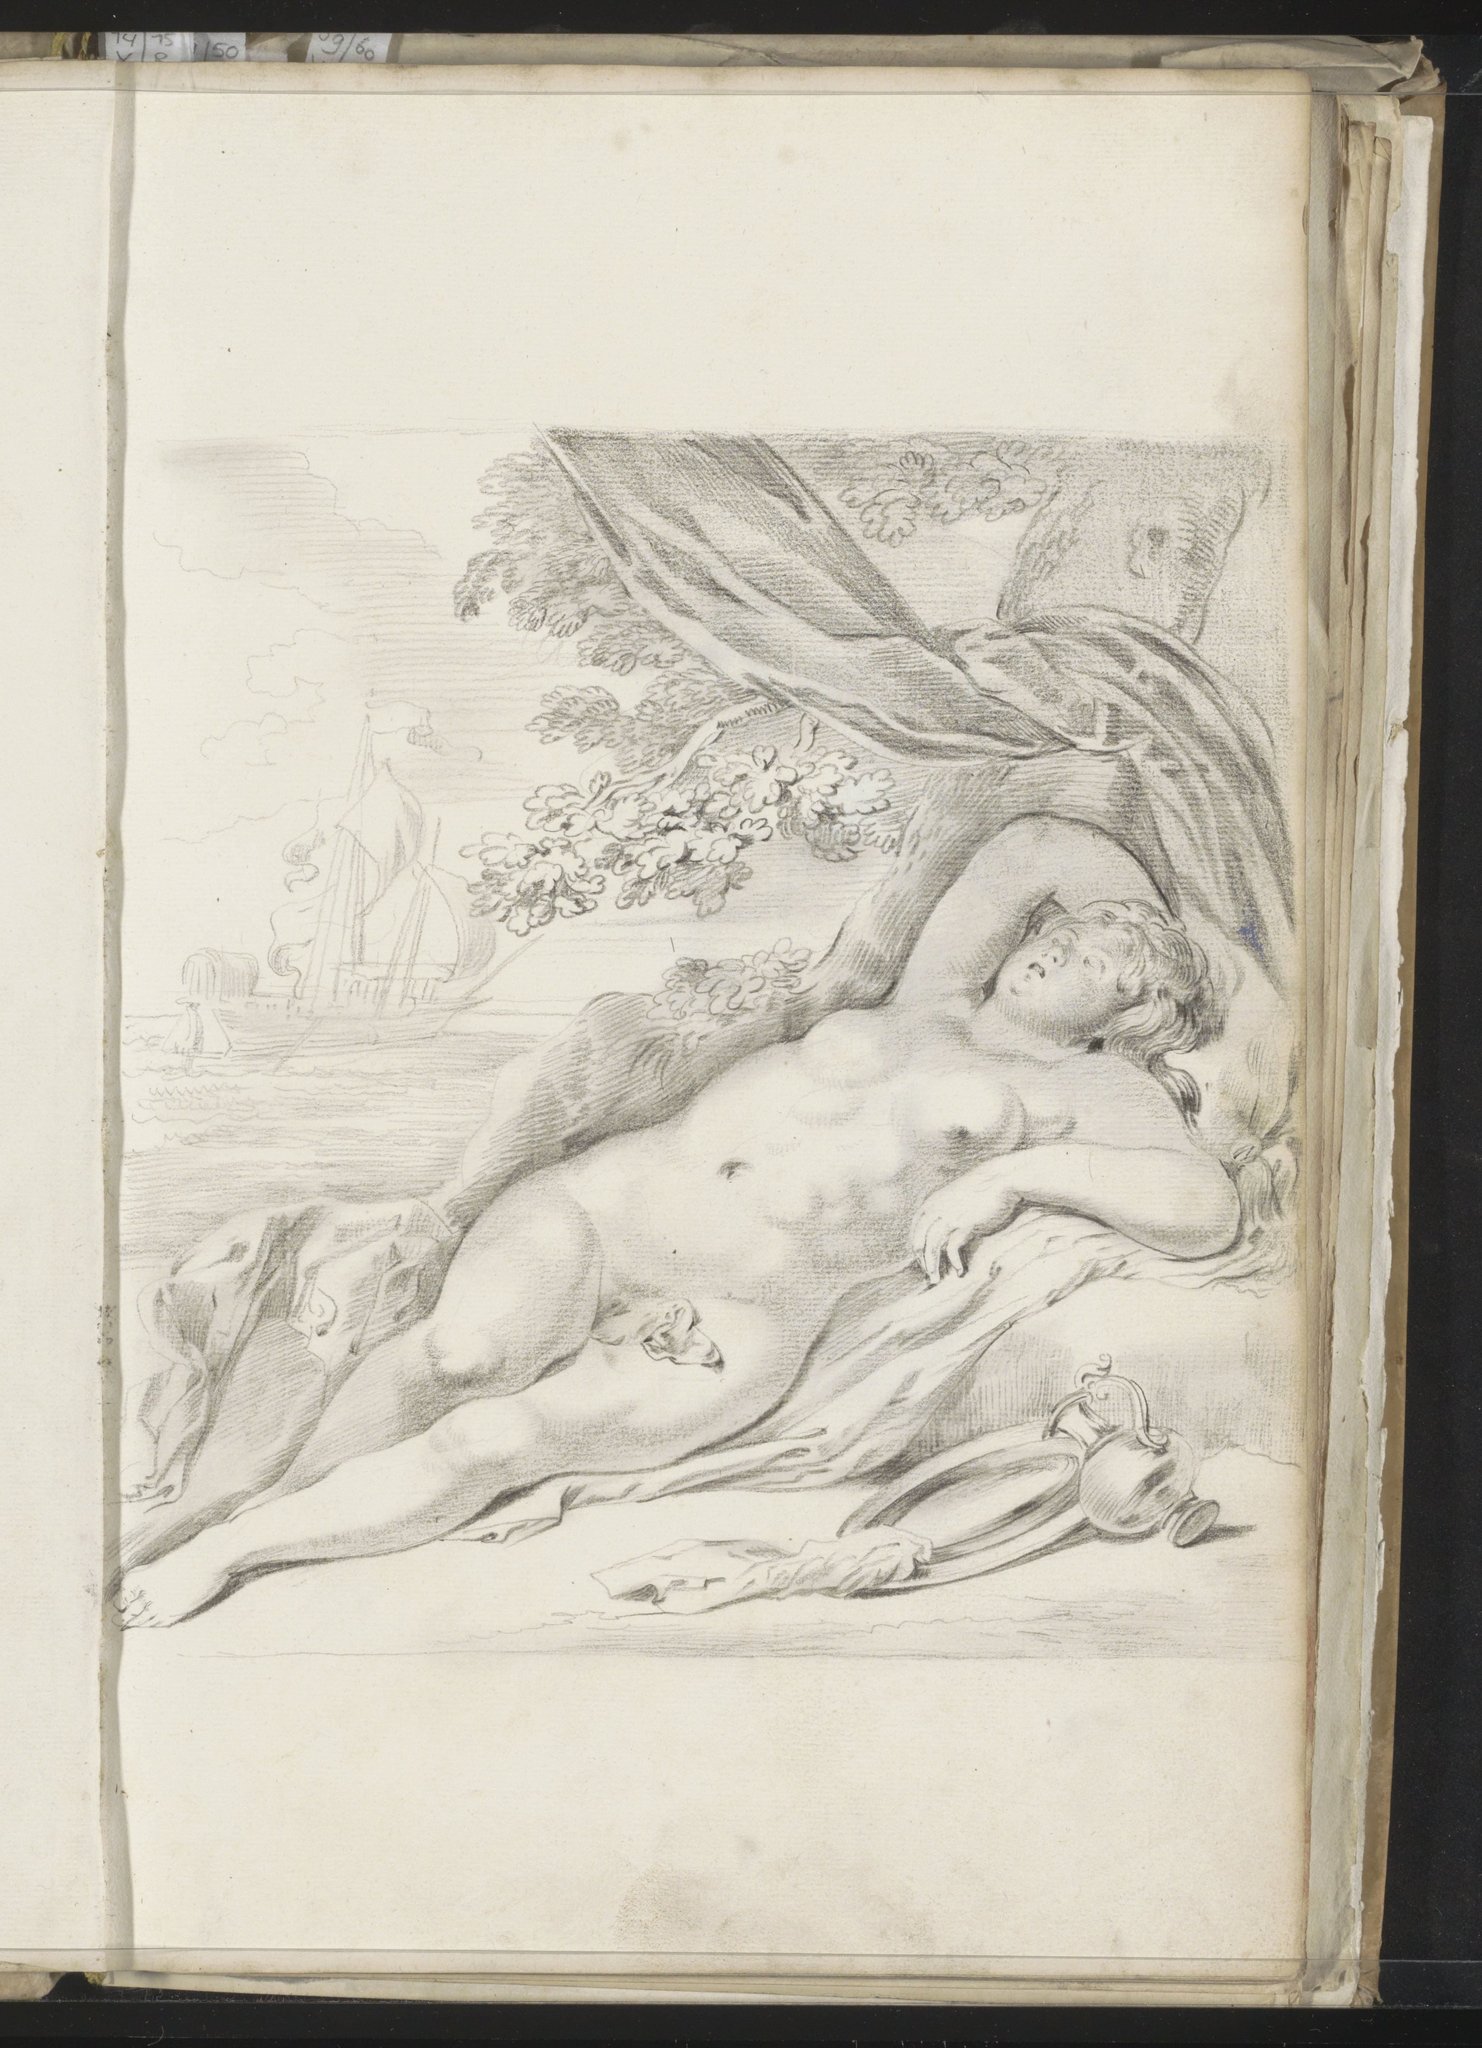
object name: sketchbook leaf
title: Slapende Venus onder een boom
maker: jacob toorenvliet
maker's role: draughtsman, painter, print maker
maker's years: 1640-1719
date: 1701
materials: chalk, paper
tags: sailing-ship, sailing-boat, venus asleep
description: De naakte Venus ligt uitgestrekt onder een boom. Op de achtergrond een tweemaster op zee. Blad 12 recto uit een schetsboek met 63 bladen.